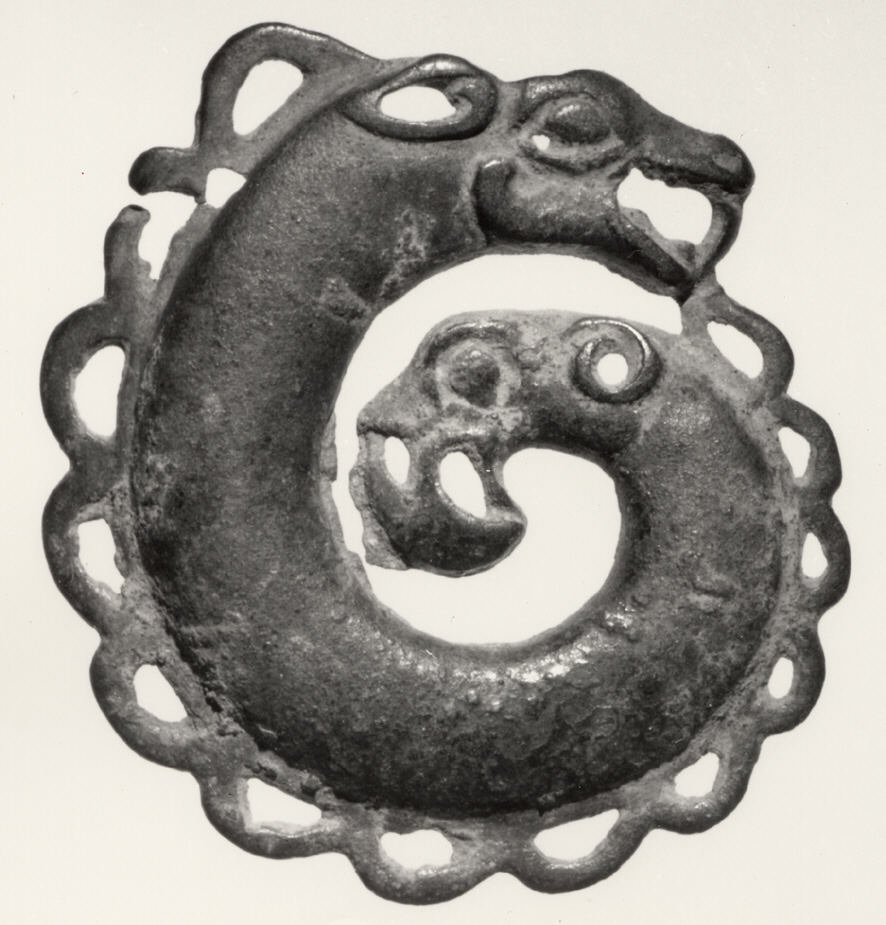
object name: plaque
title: Plaque in the Shape of a Coiled, Two-Headed Animal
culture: north chinese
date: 500-301 BCE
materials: gilt bronze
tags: animals